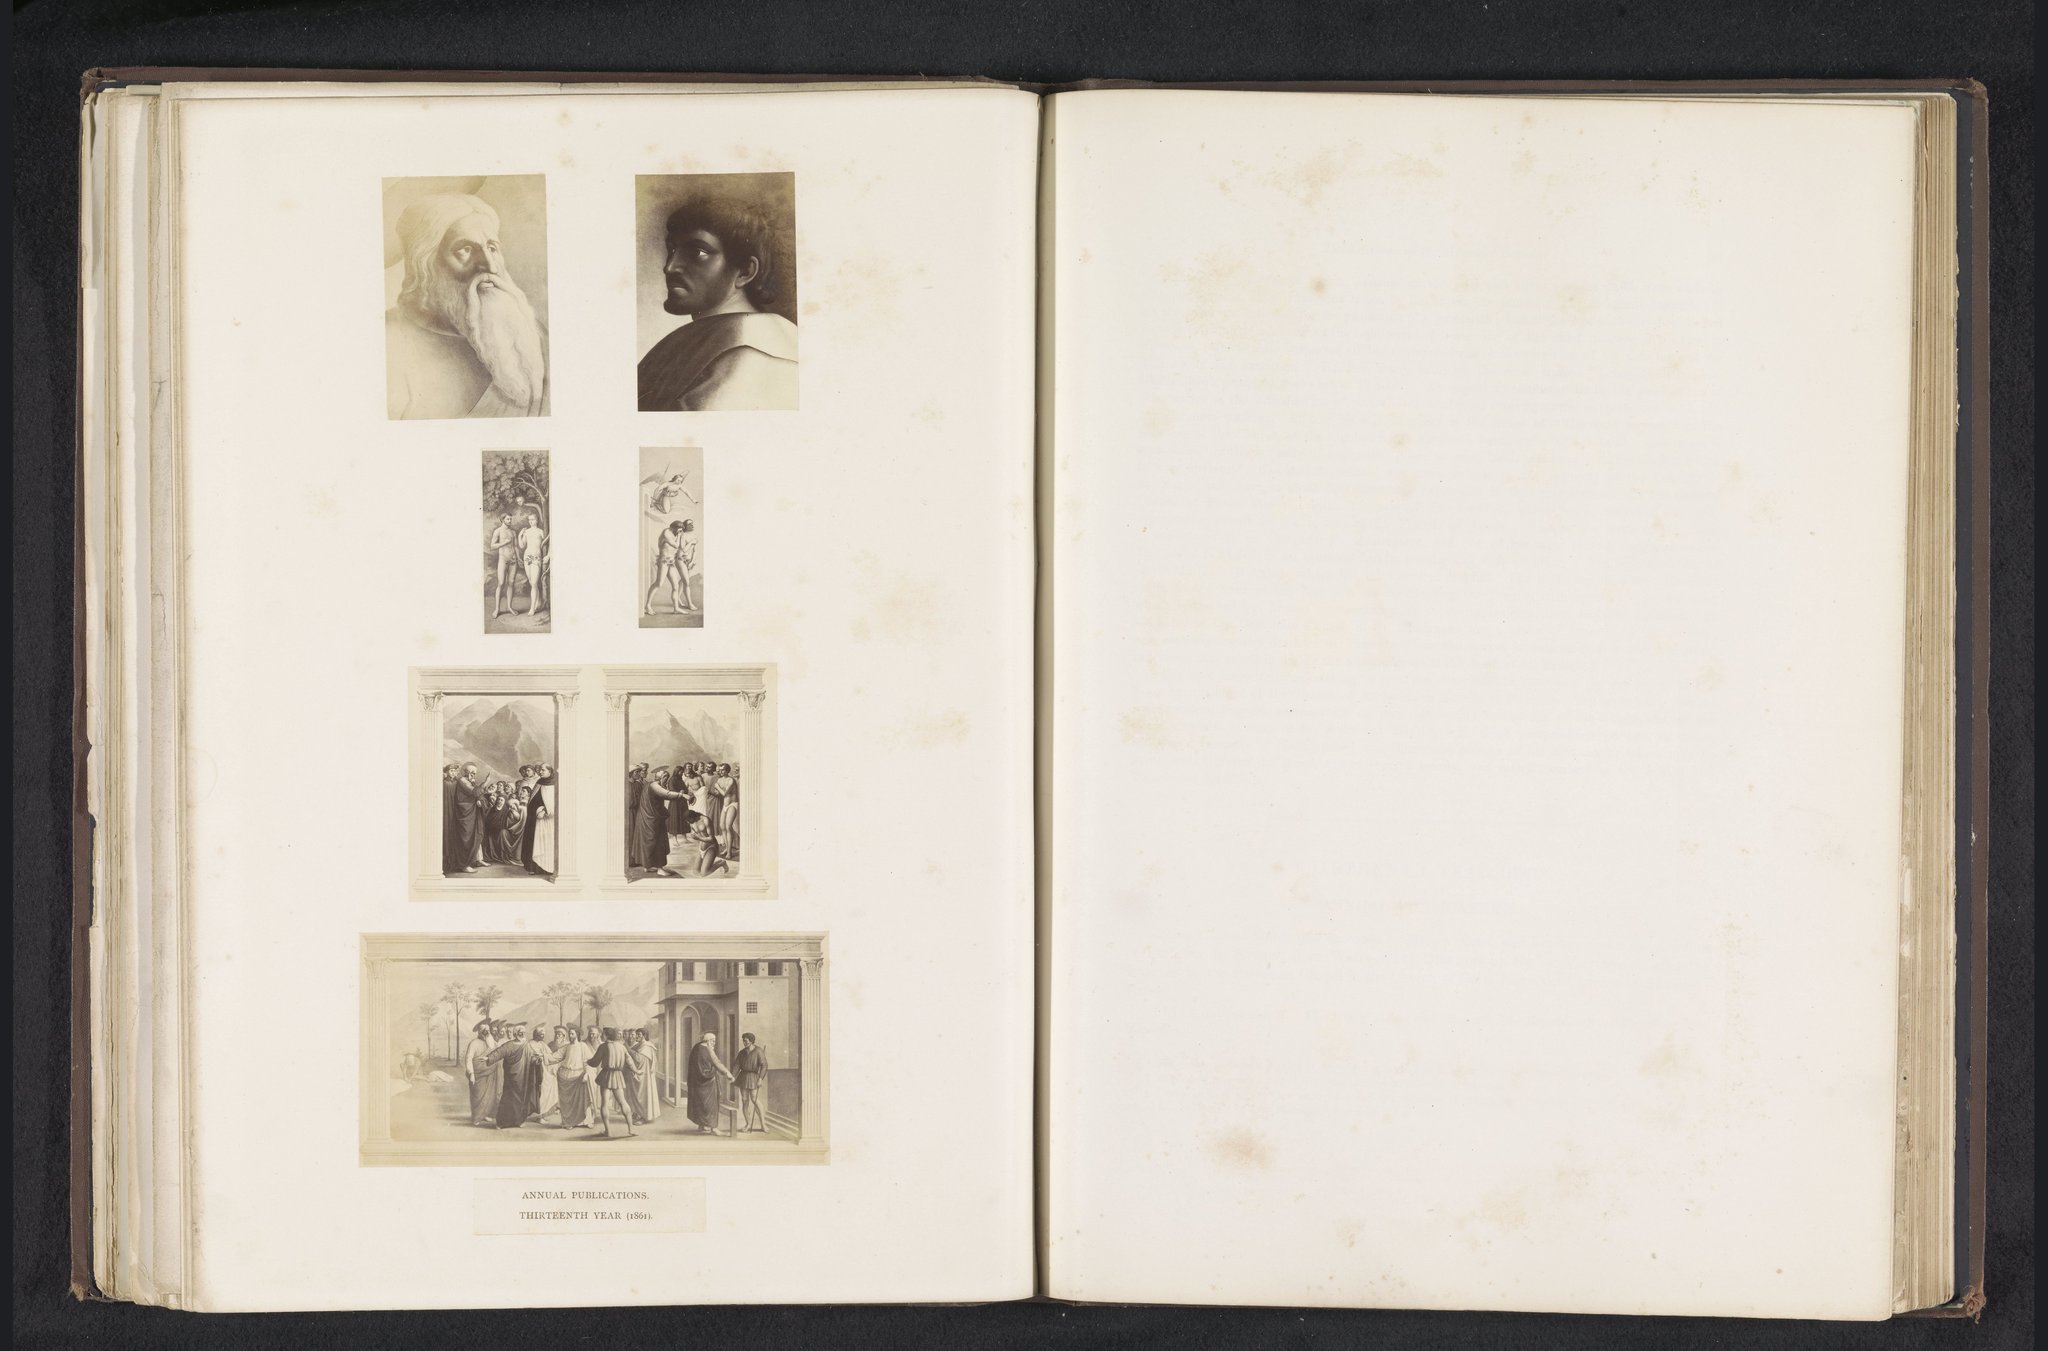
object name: photograph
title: Zes fotoreproducties van een publicatie door de Arundel Society met schilderijen door Masaccio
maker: Anonymous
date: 1859-1869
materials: photographic support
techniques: albumen print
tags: book, painting (including book-illumination, miniature-painting)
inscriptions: inscription: ‘Annual publications, thirteenth year (1861).’